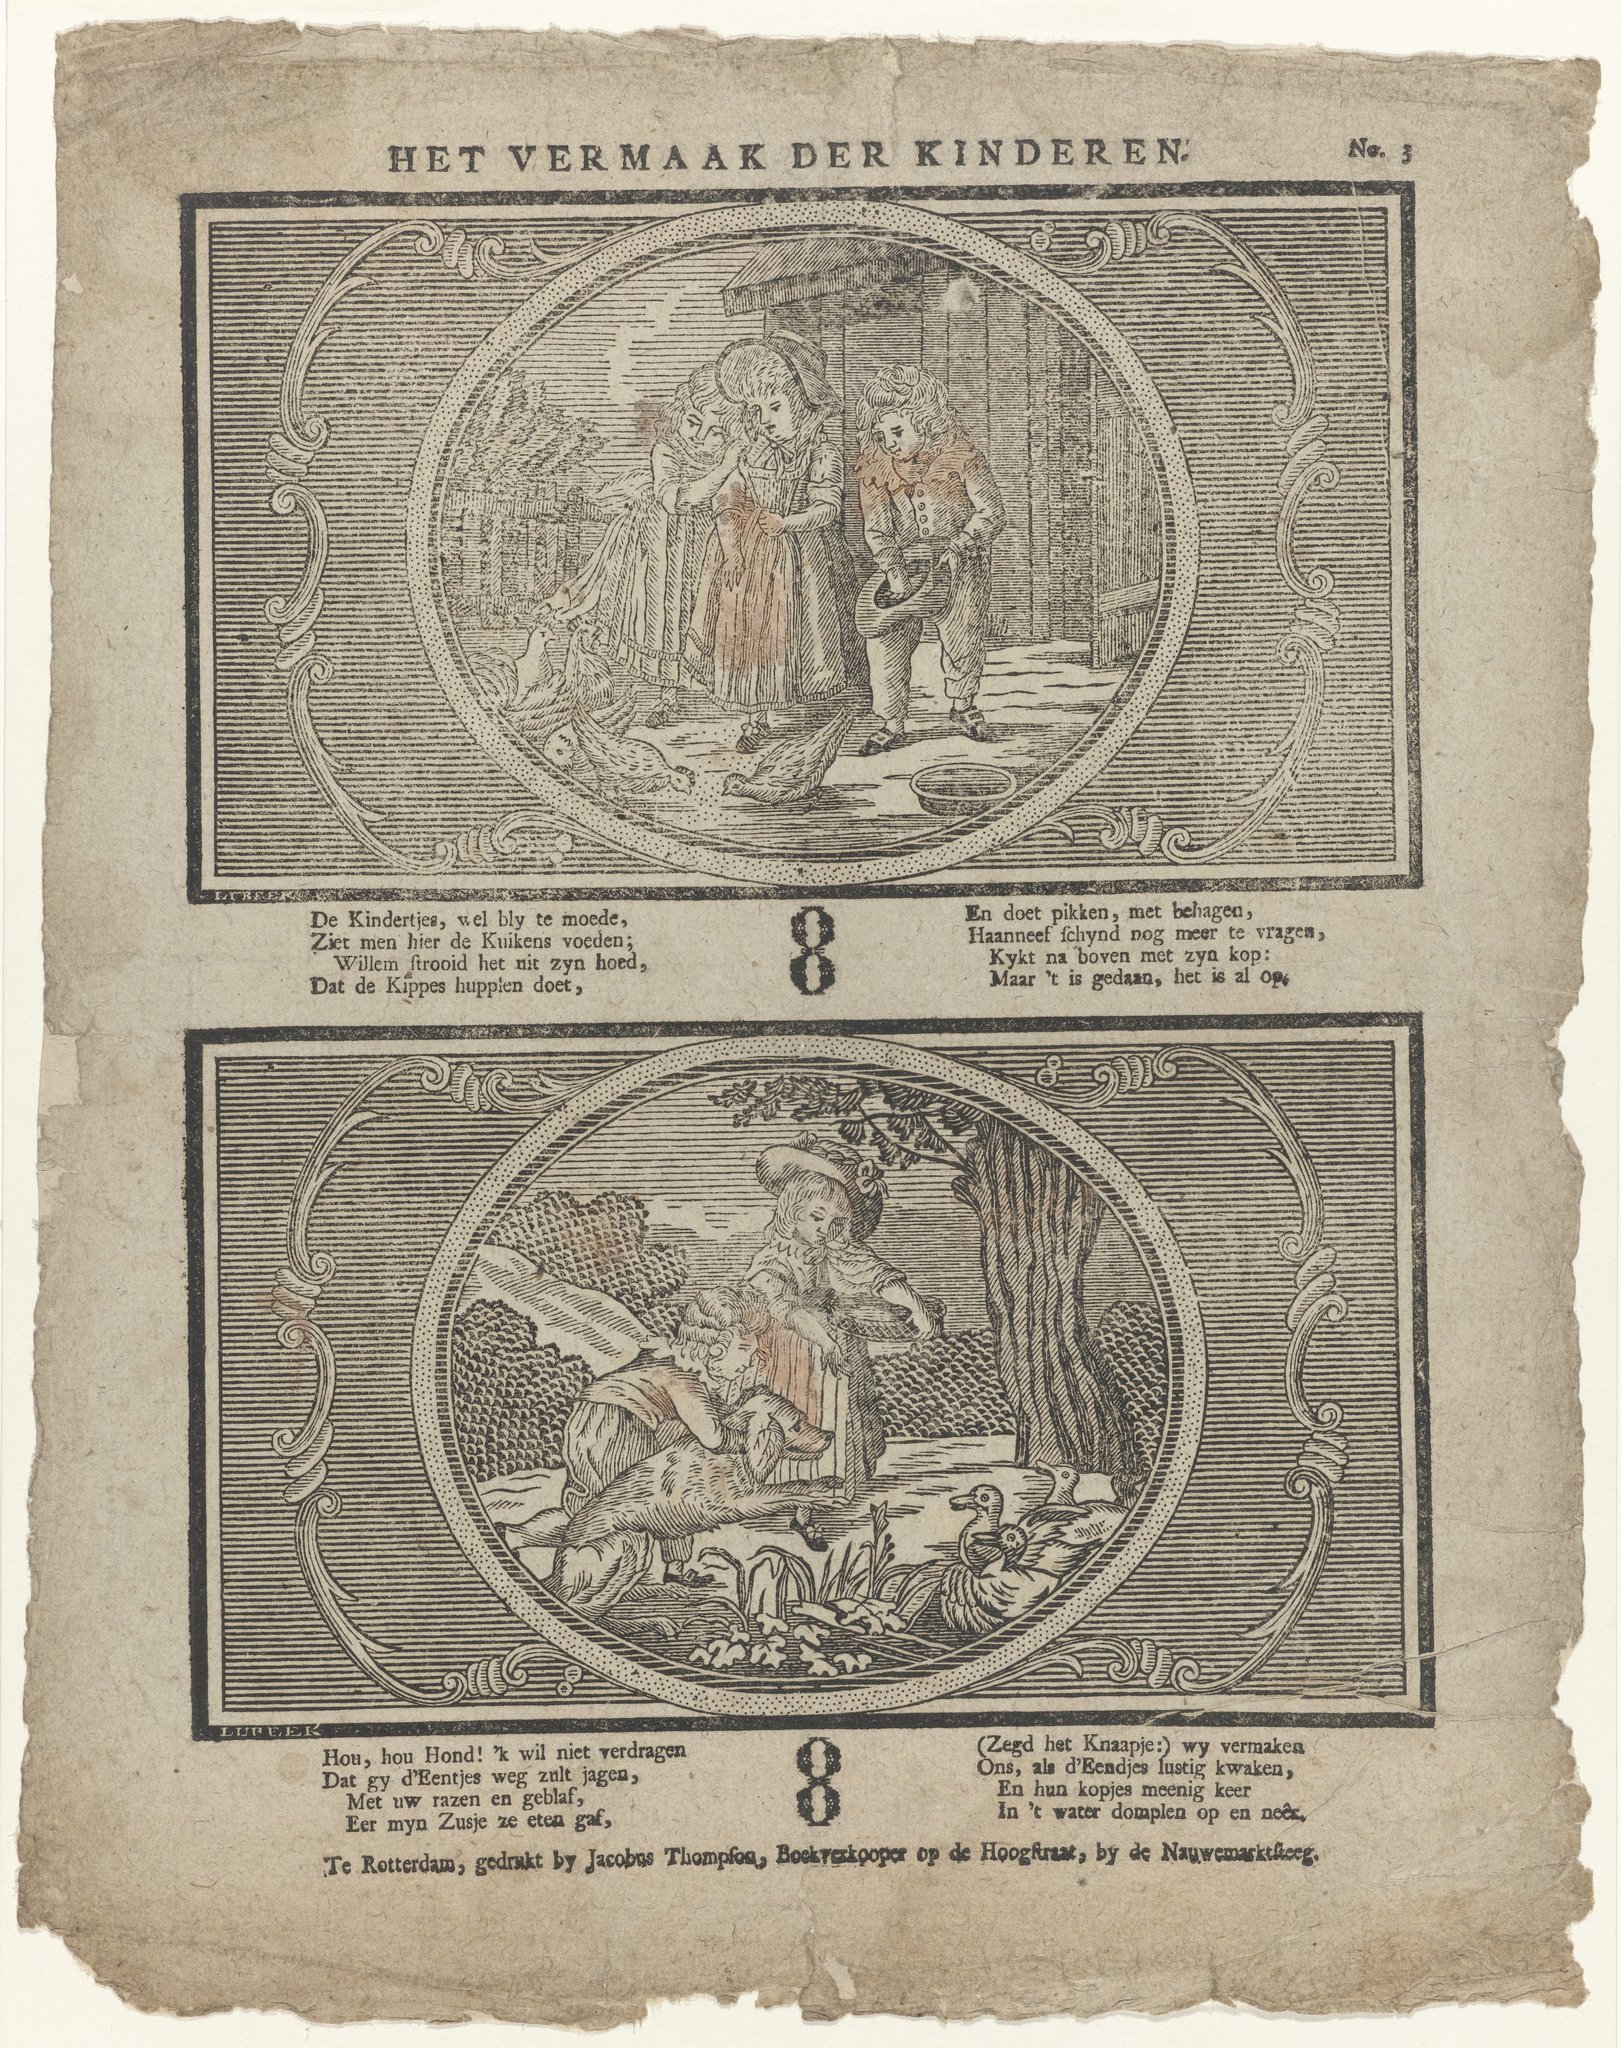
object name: popular print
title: Het vermaak der kinderen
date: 1791-1812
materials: paper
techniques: colour, letterpress printing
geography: rotterdam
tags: giving food, child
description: Blad met 2 voorstellingen van kindervermaken in lijsten. Boven: drie kinderen die kippen voeren. Onder: een meisje dat eendjes voert en een jongen die een hond tegenhoudt de eenden weg te jagen. Onder elke afbeelding een achtregelig vers in twee kolommen. Genummerd rechtsboven: No. 3.